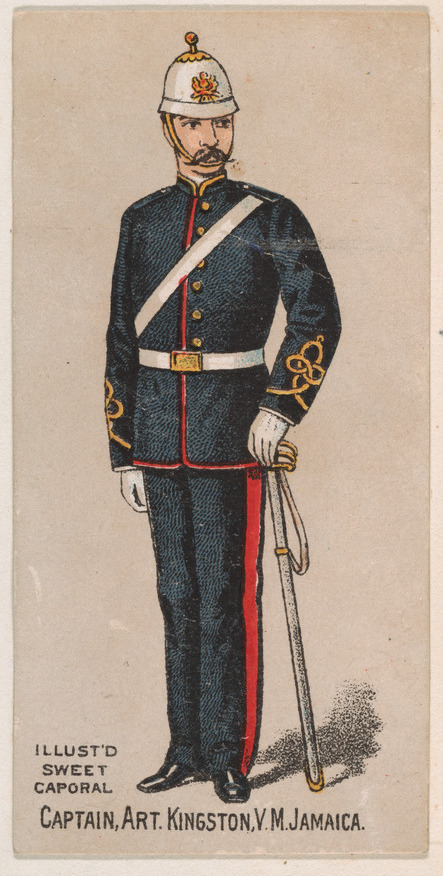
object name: print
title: Captain, Artillery, Kingston, V.M. Jamaica, from the Military Series (N224) issued by Kinney Tobacco Company to promote Sweet Caporal Cigarettes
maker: kinney brothers tobacco company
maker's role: publisher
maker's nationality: american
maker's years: 1869-2011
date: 1888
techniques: color lithograph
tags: military,men